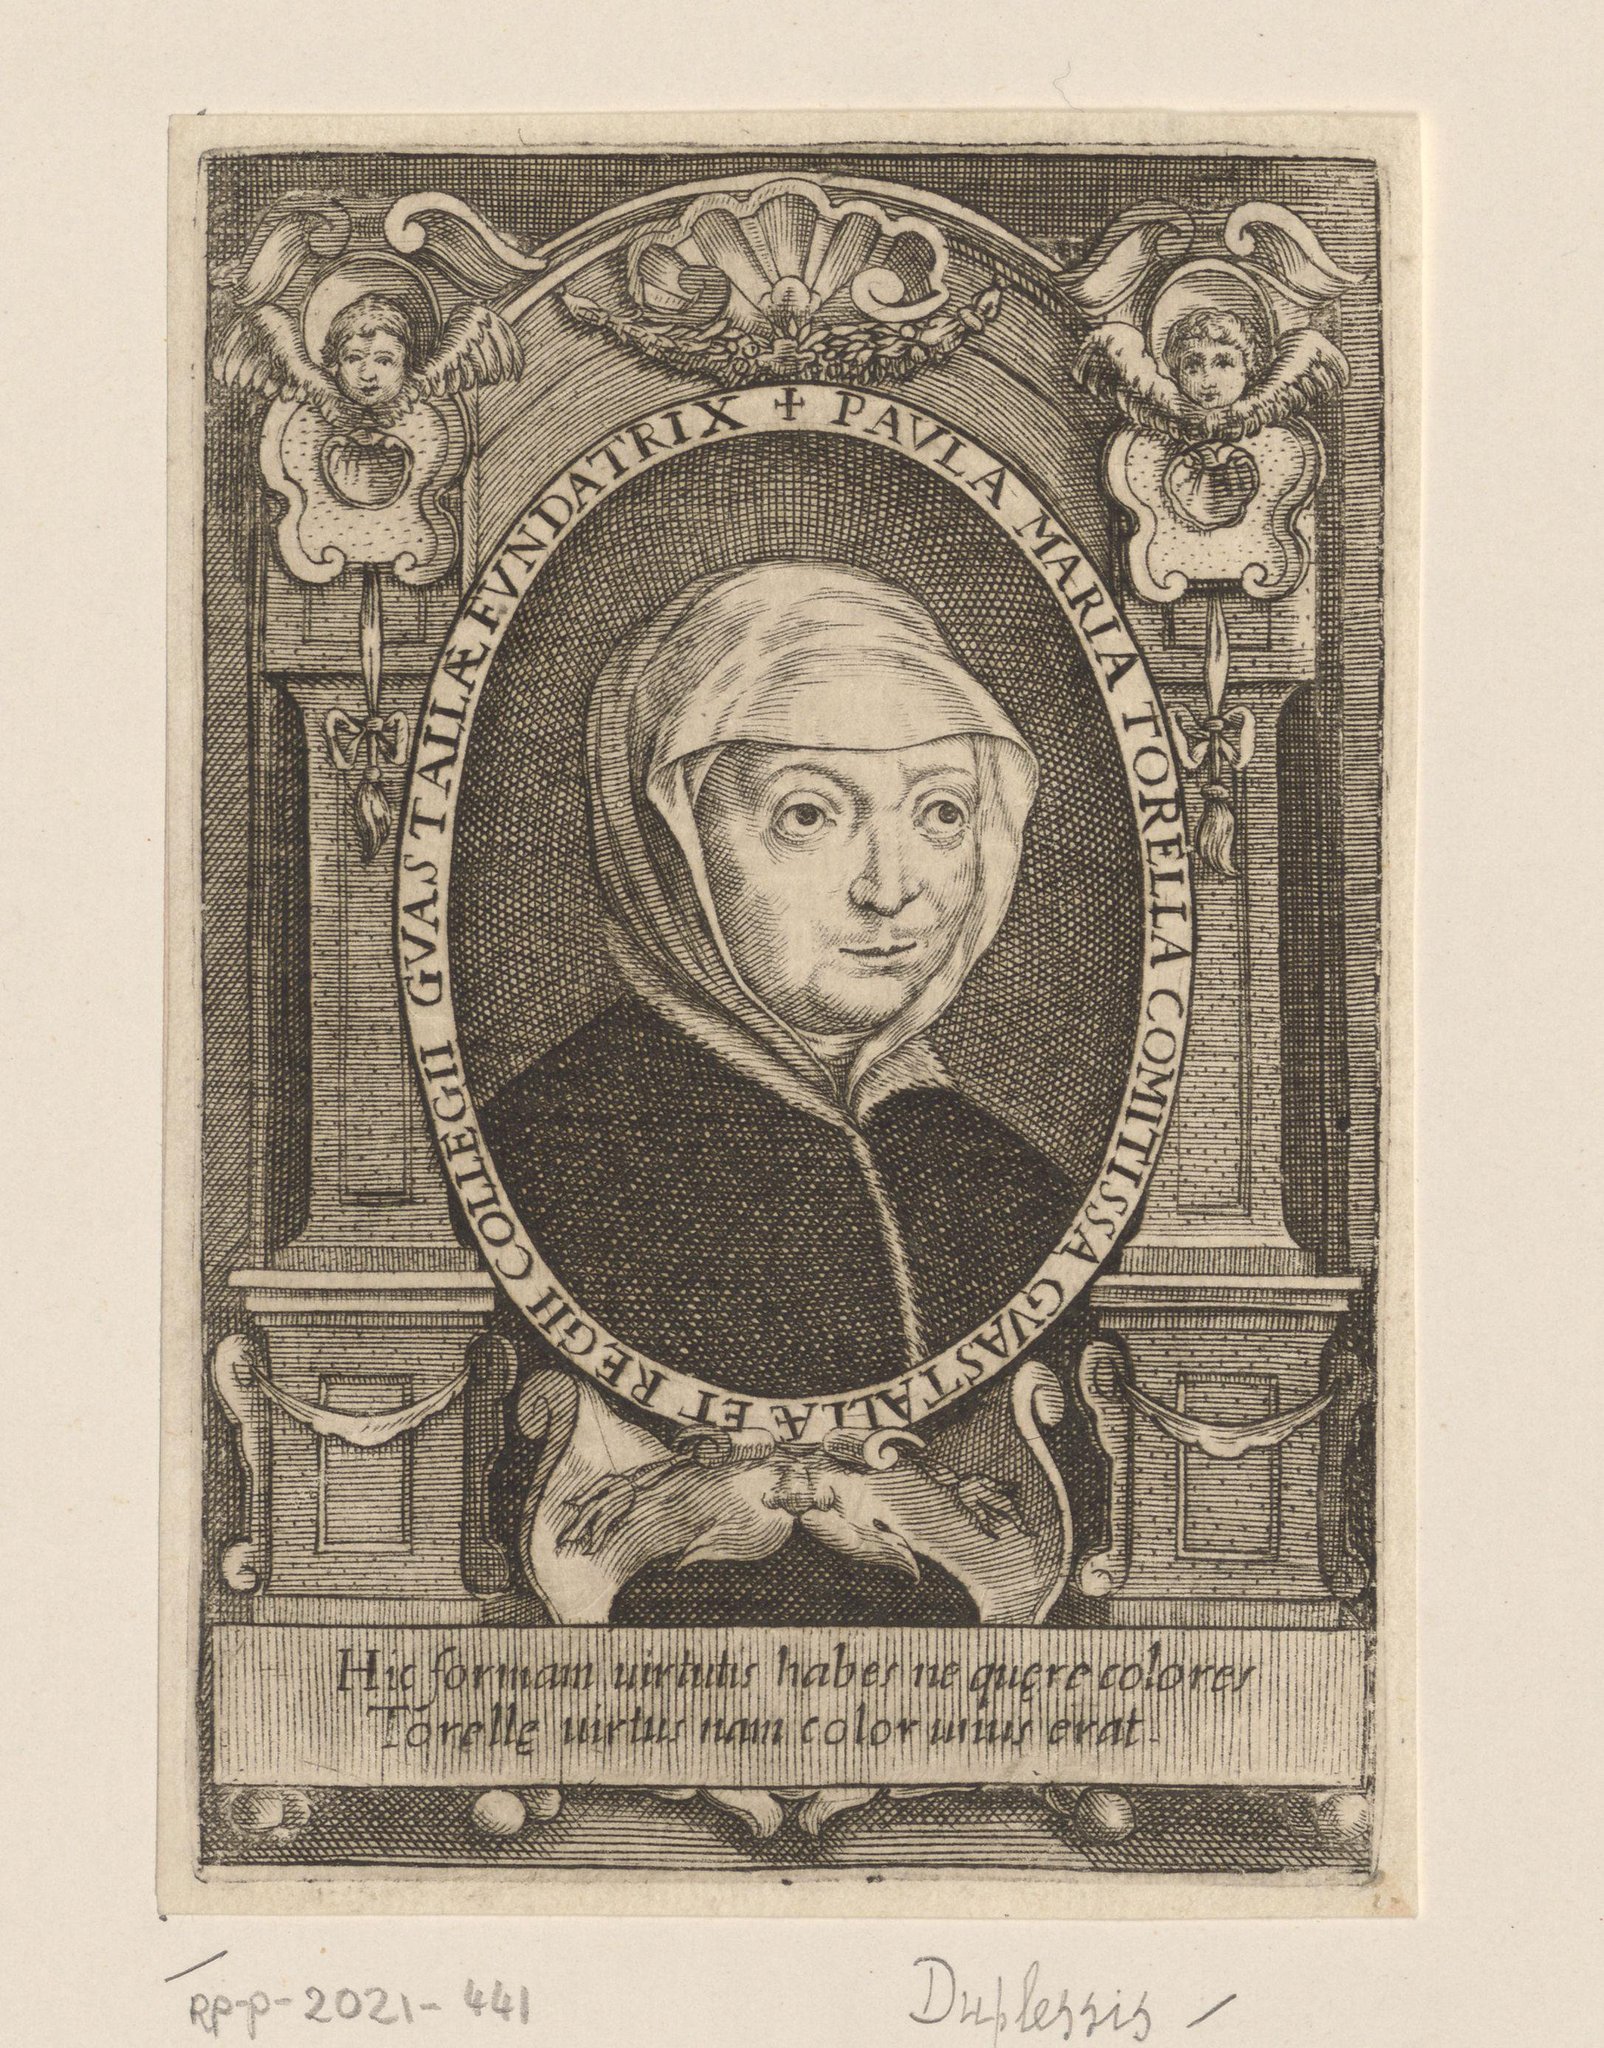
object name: print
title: Portret van Ludovica Torelli, gravin van Guastalla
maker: Anonymous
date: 1600-1700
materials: paper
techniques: engraving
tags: politician, historical persons, politician, e.g. party leader